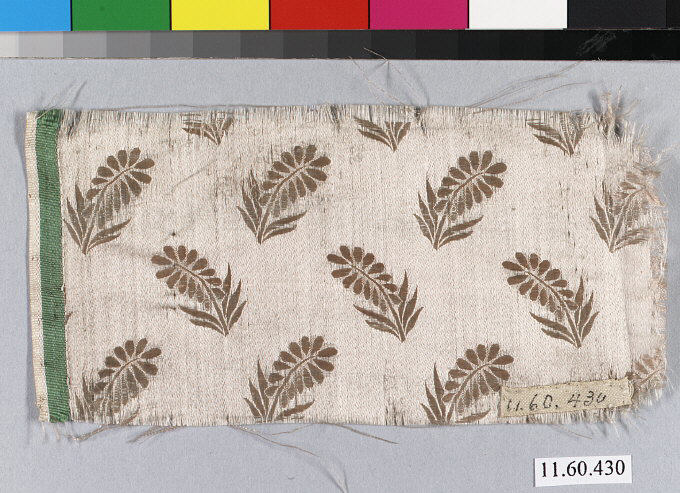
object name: fragment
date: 1801-1900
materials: silk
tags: leaves